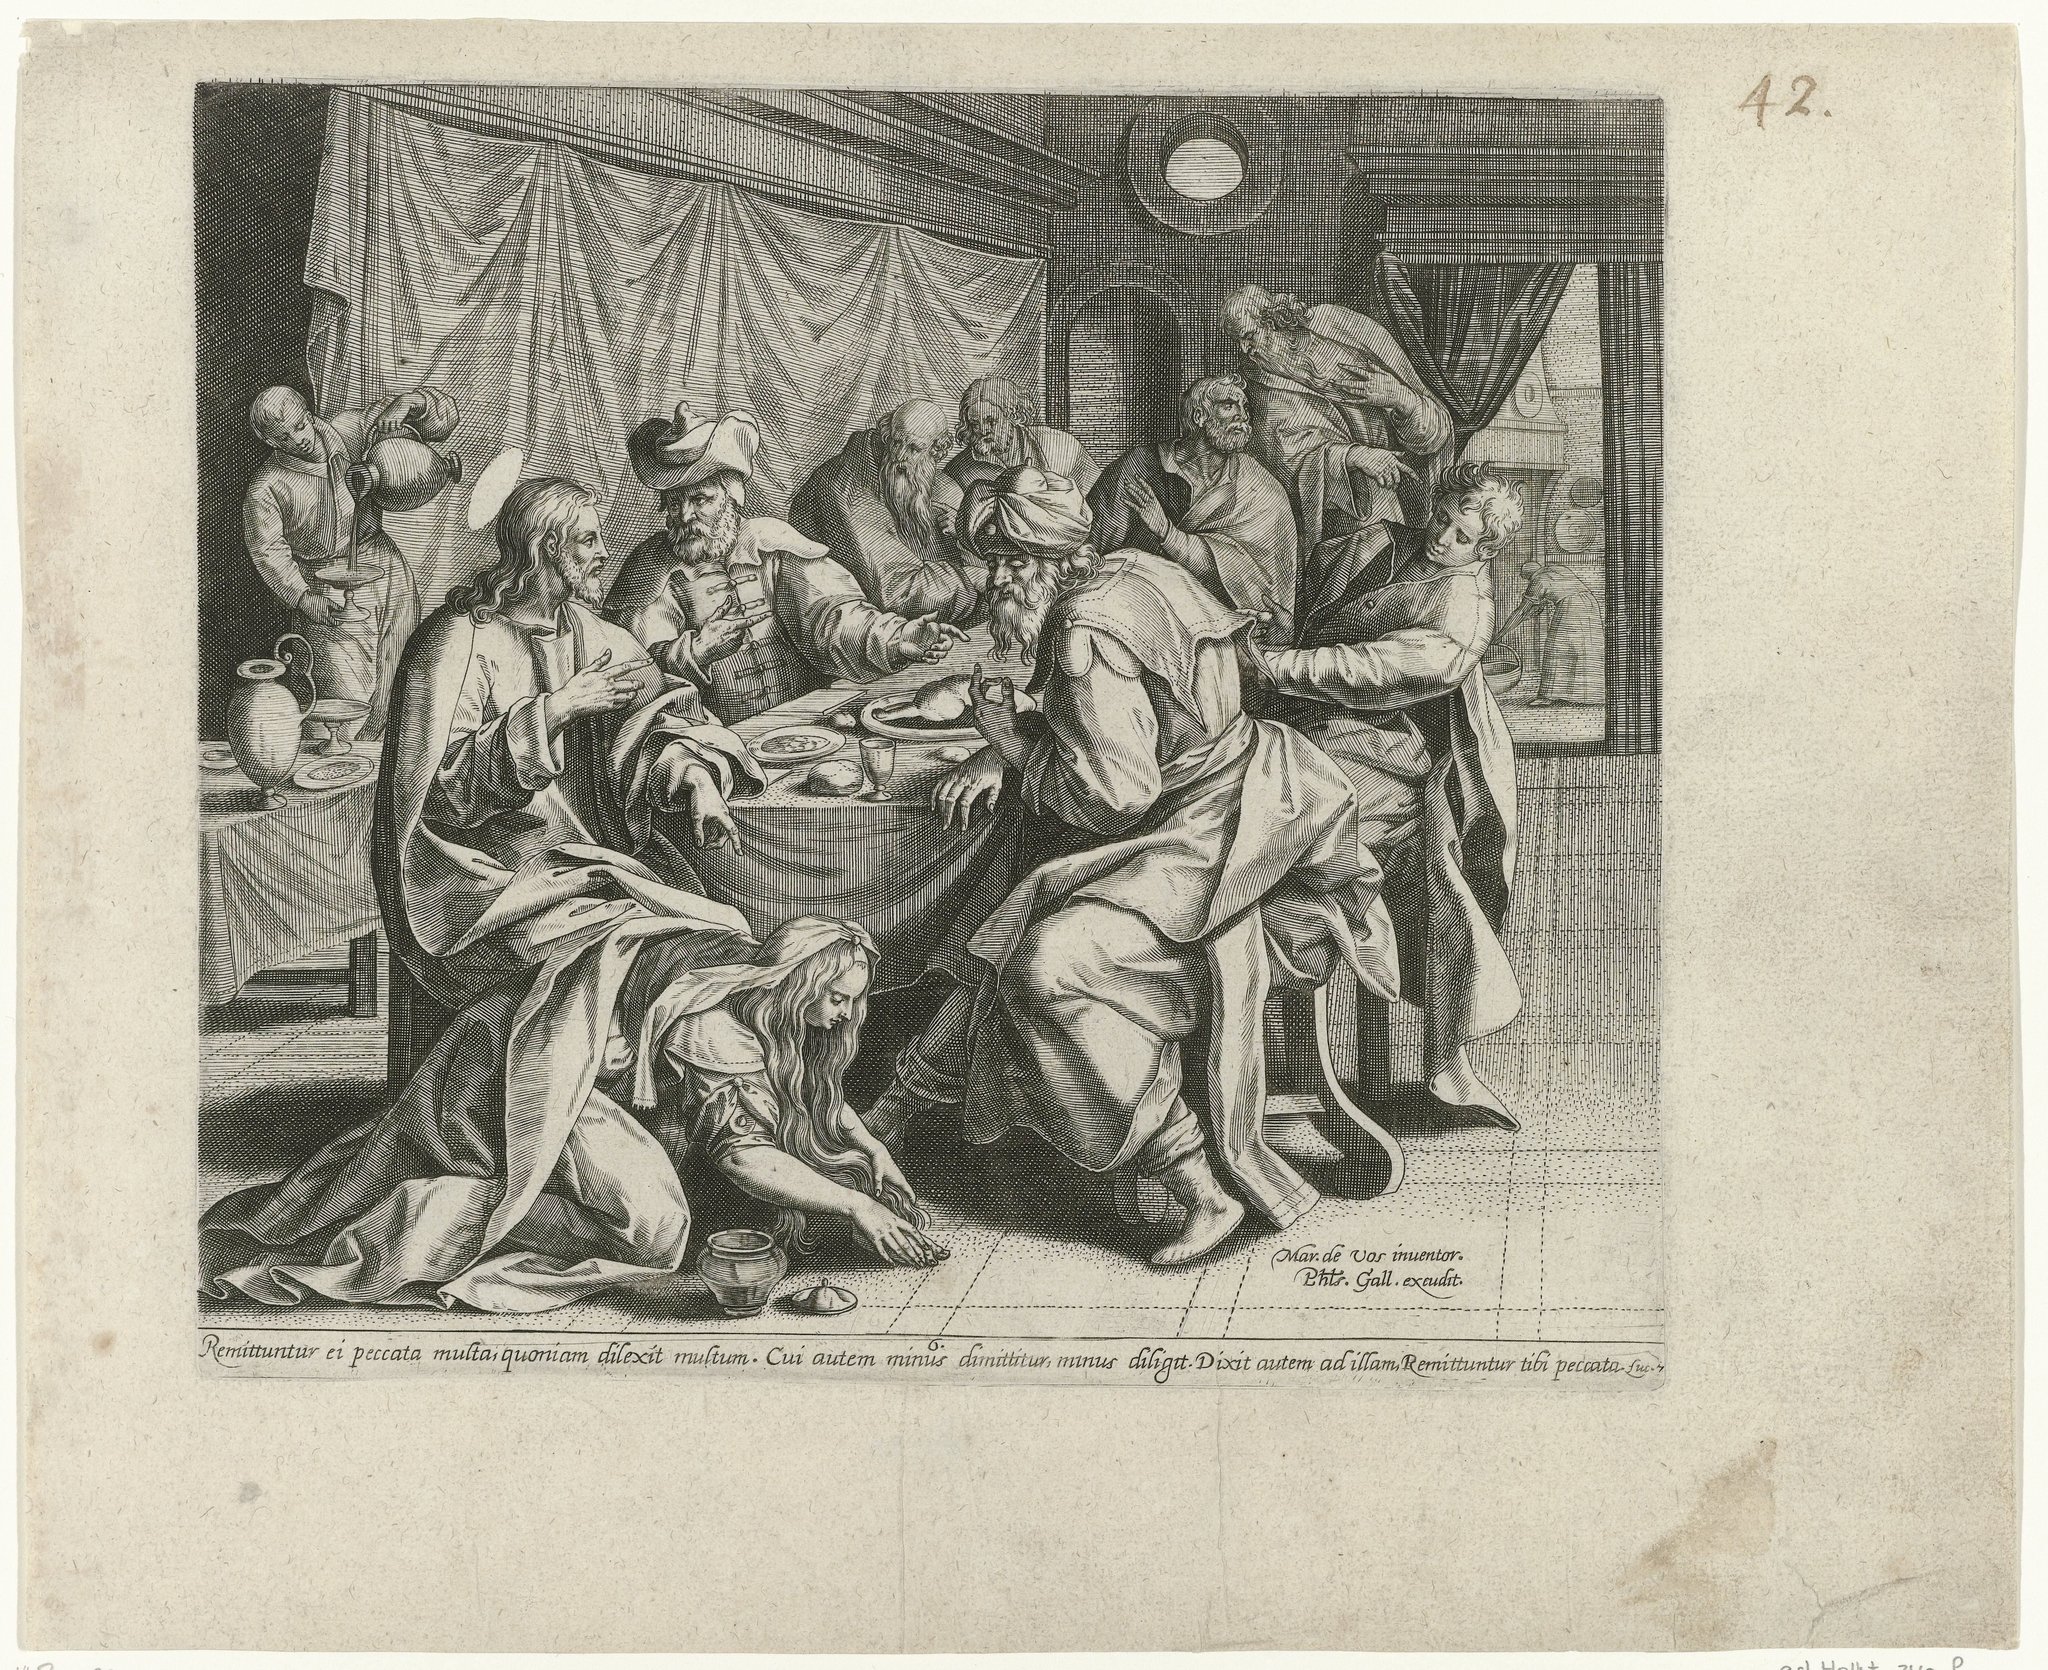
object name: print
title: Typus Divinae indulgentiae atqz misericordiae, erga eos quibus ex toto corde transgressionum poeni tet et ad dnm deum se convertunt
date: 1547-1612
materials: paper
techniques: engraving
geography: antwerp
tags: a woman washes christ's feet with her tears, and wipes them with her hair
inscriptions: number: ‘42’, collector's mark: Lugt 2228, collector's mark: Lugt 2760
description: In het huis van Simon wast een zondige vrouw (Maria Magdalena) de voeten van Christus met haar tranen en droogt zij ze met haar haren. Christus vergeeft haar zonden. De prent heeft een Latijns onderschrift en is deel van een serie over boetedoening en berouw in het Oude en het Nieuwe Testament.